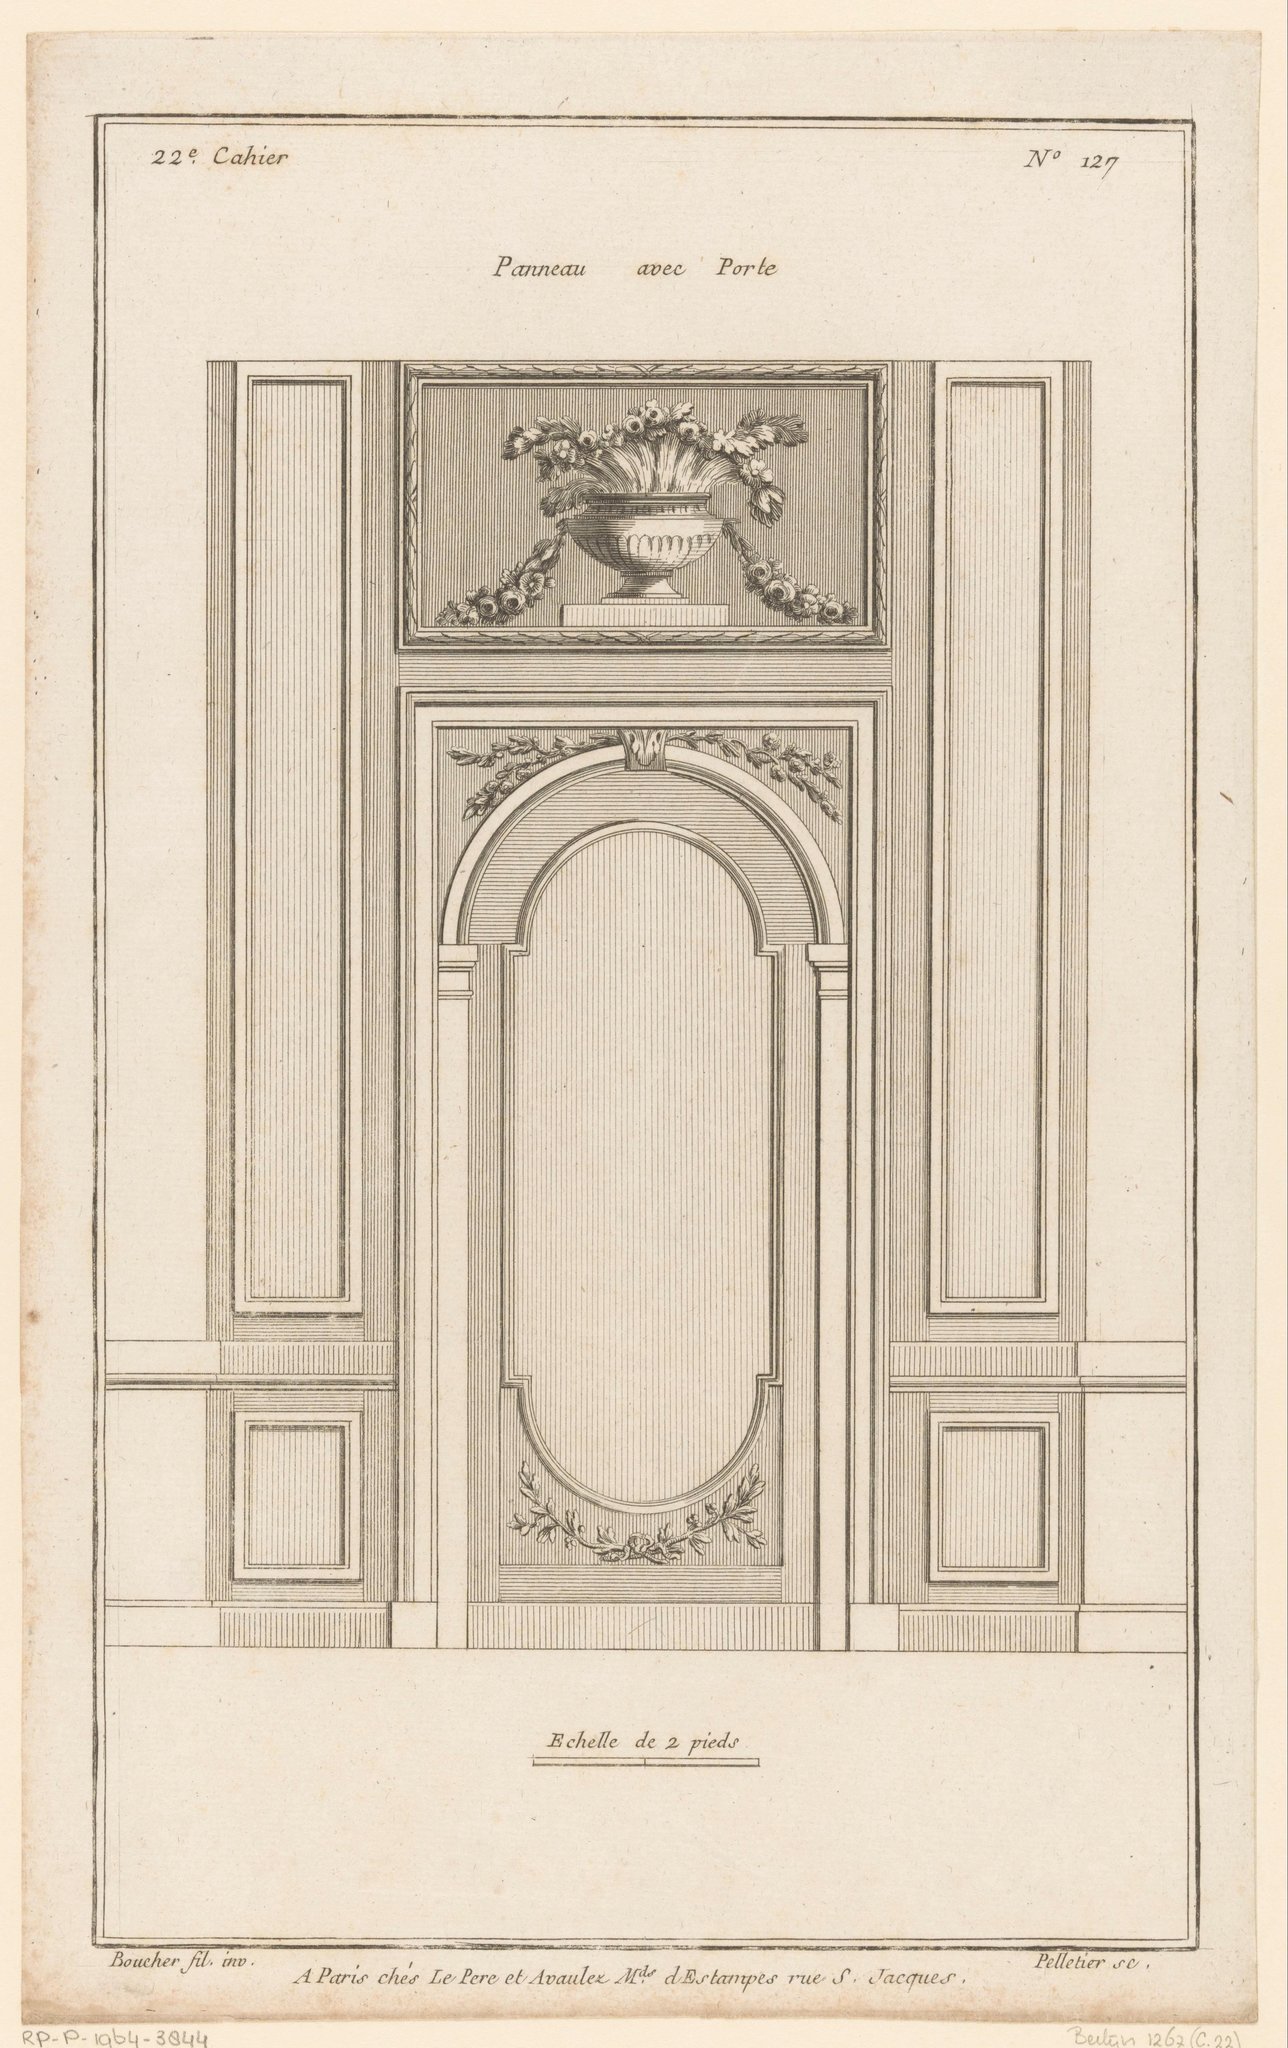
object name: print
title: Deur en panelen met vaas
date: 1772-1779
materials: paper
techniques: engraving, etching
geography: paris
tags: panelling, door, flowers in a vase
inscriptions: collector's mark: Lugt 2228, collector's mark: Lugt 2760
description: Wanddecoratie met een deur met ranken en aan weerszijden panelen. Aan de bovenzijde een paneel met bloemen in een vaas en guirlandes. Prentnummer 127.